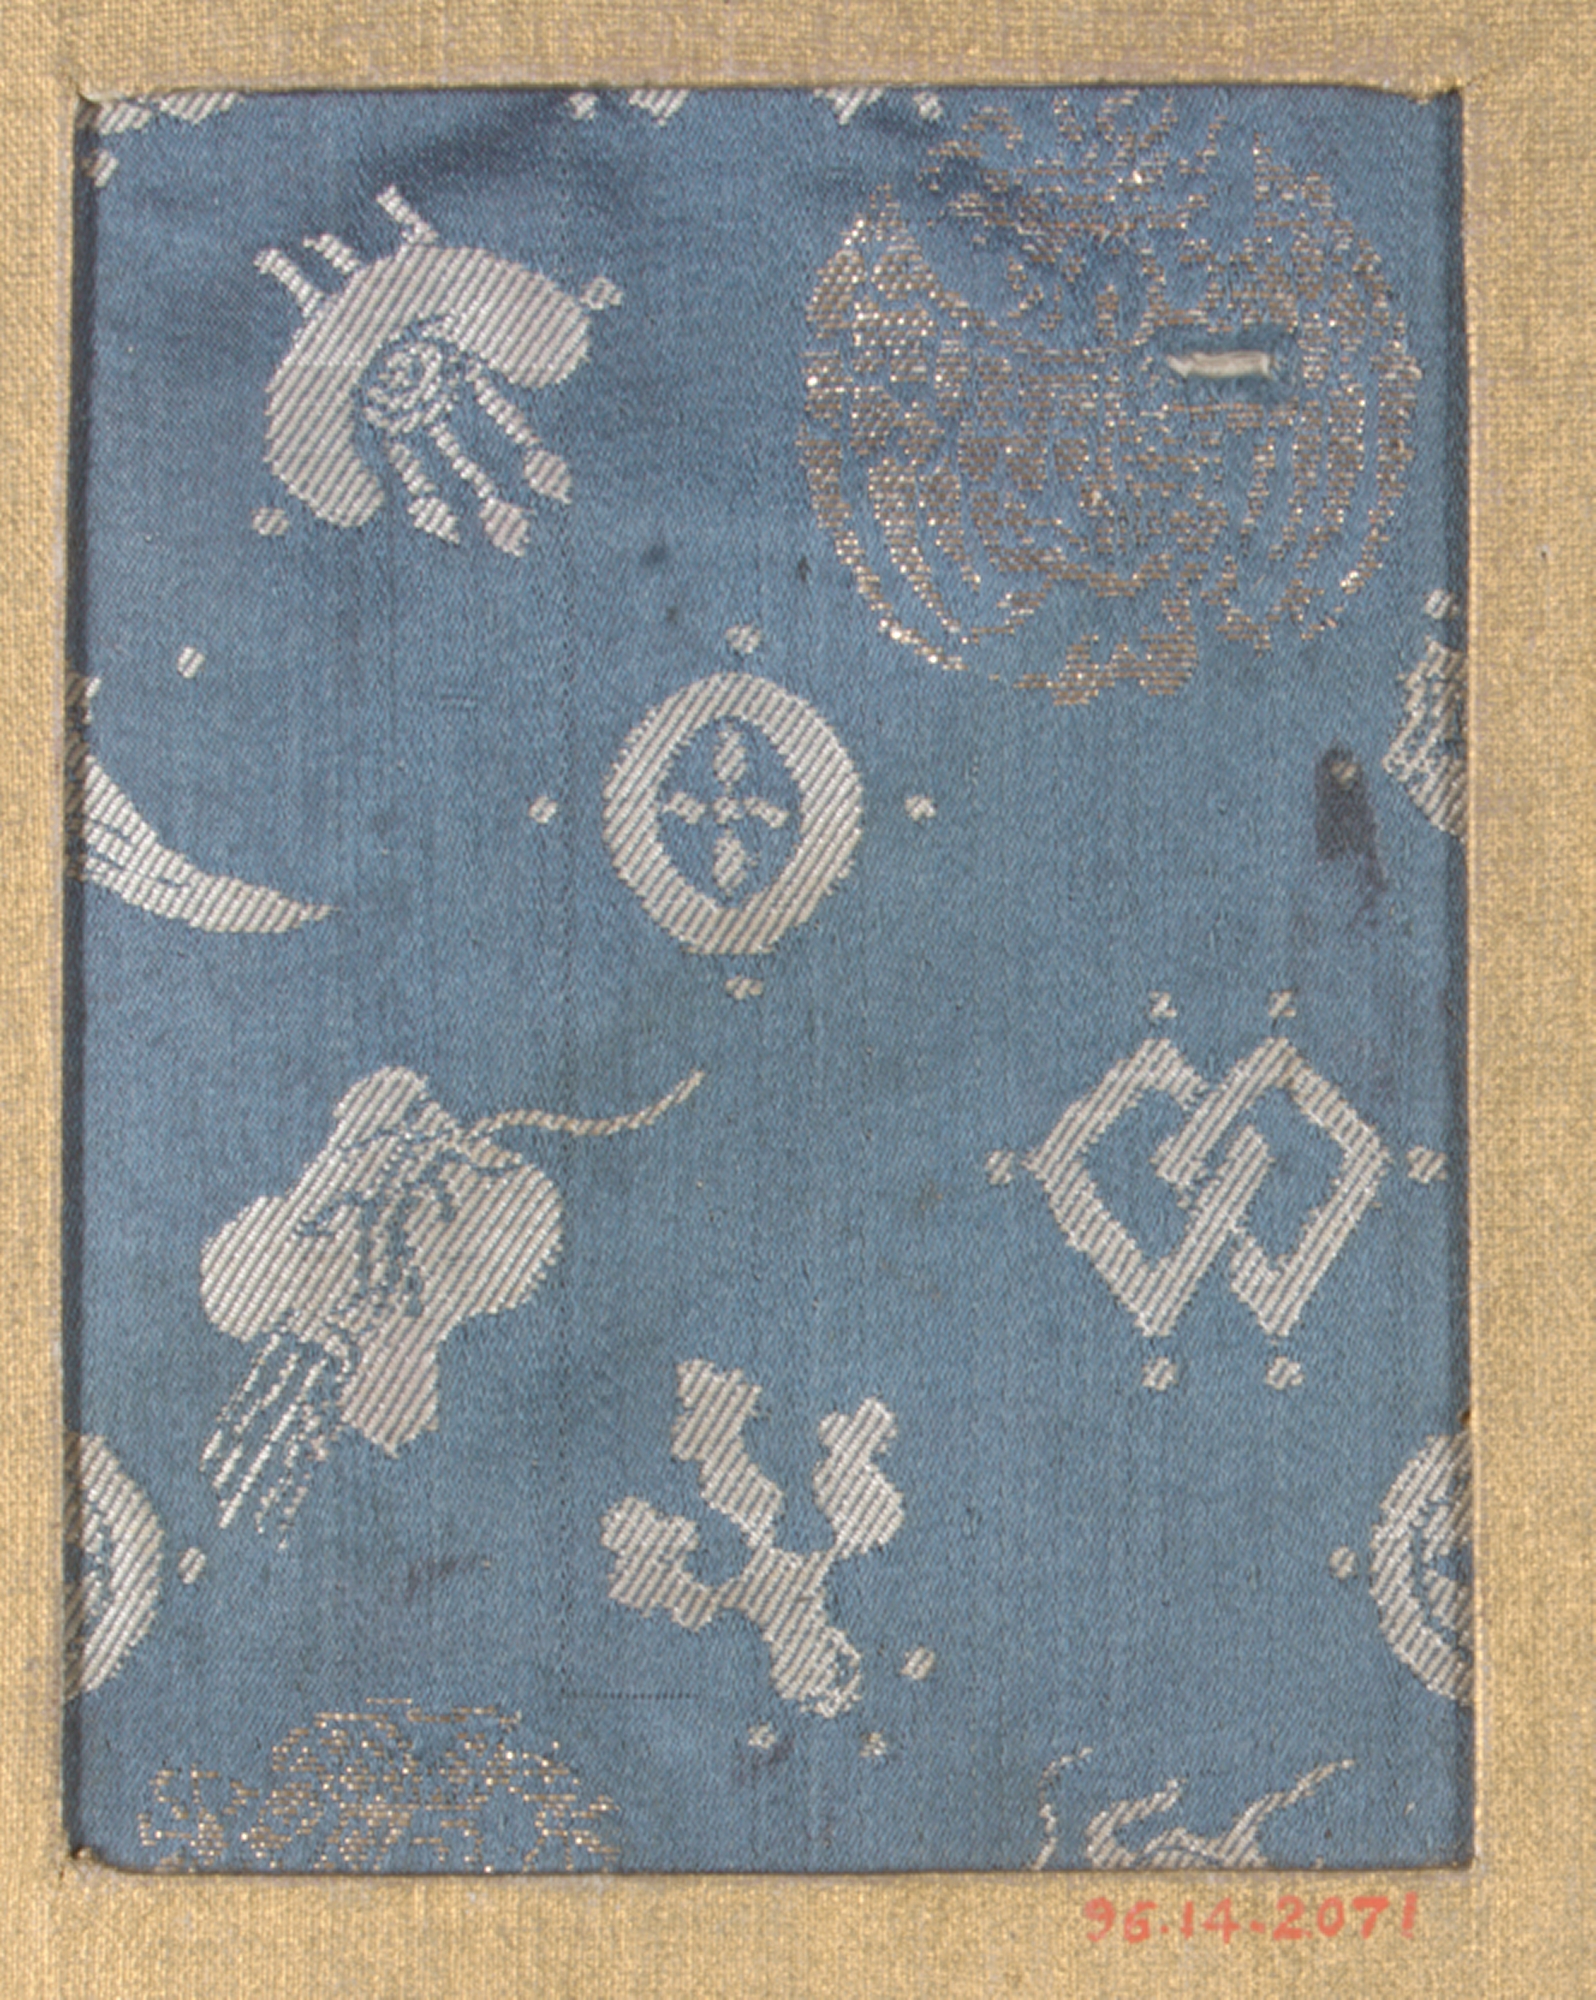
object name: piece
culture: japanese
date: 1701-1900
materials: silk